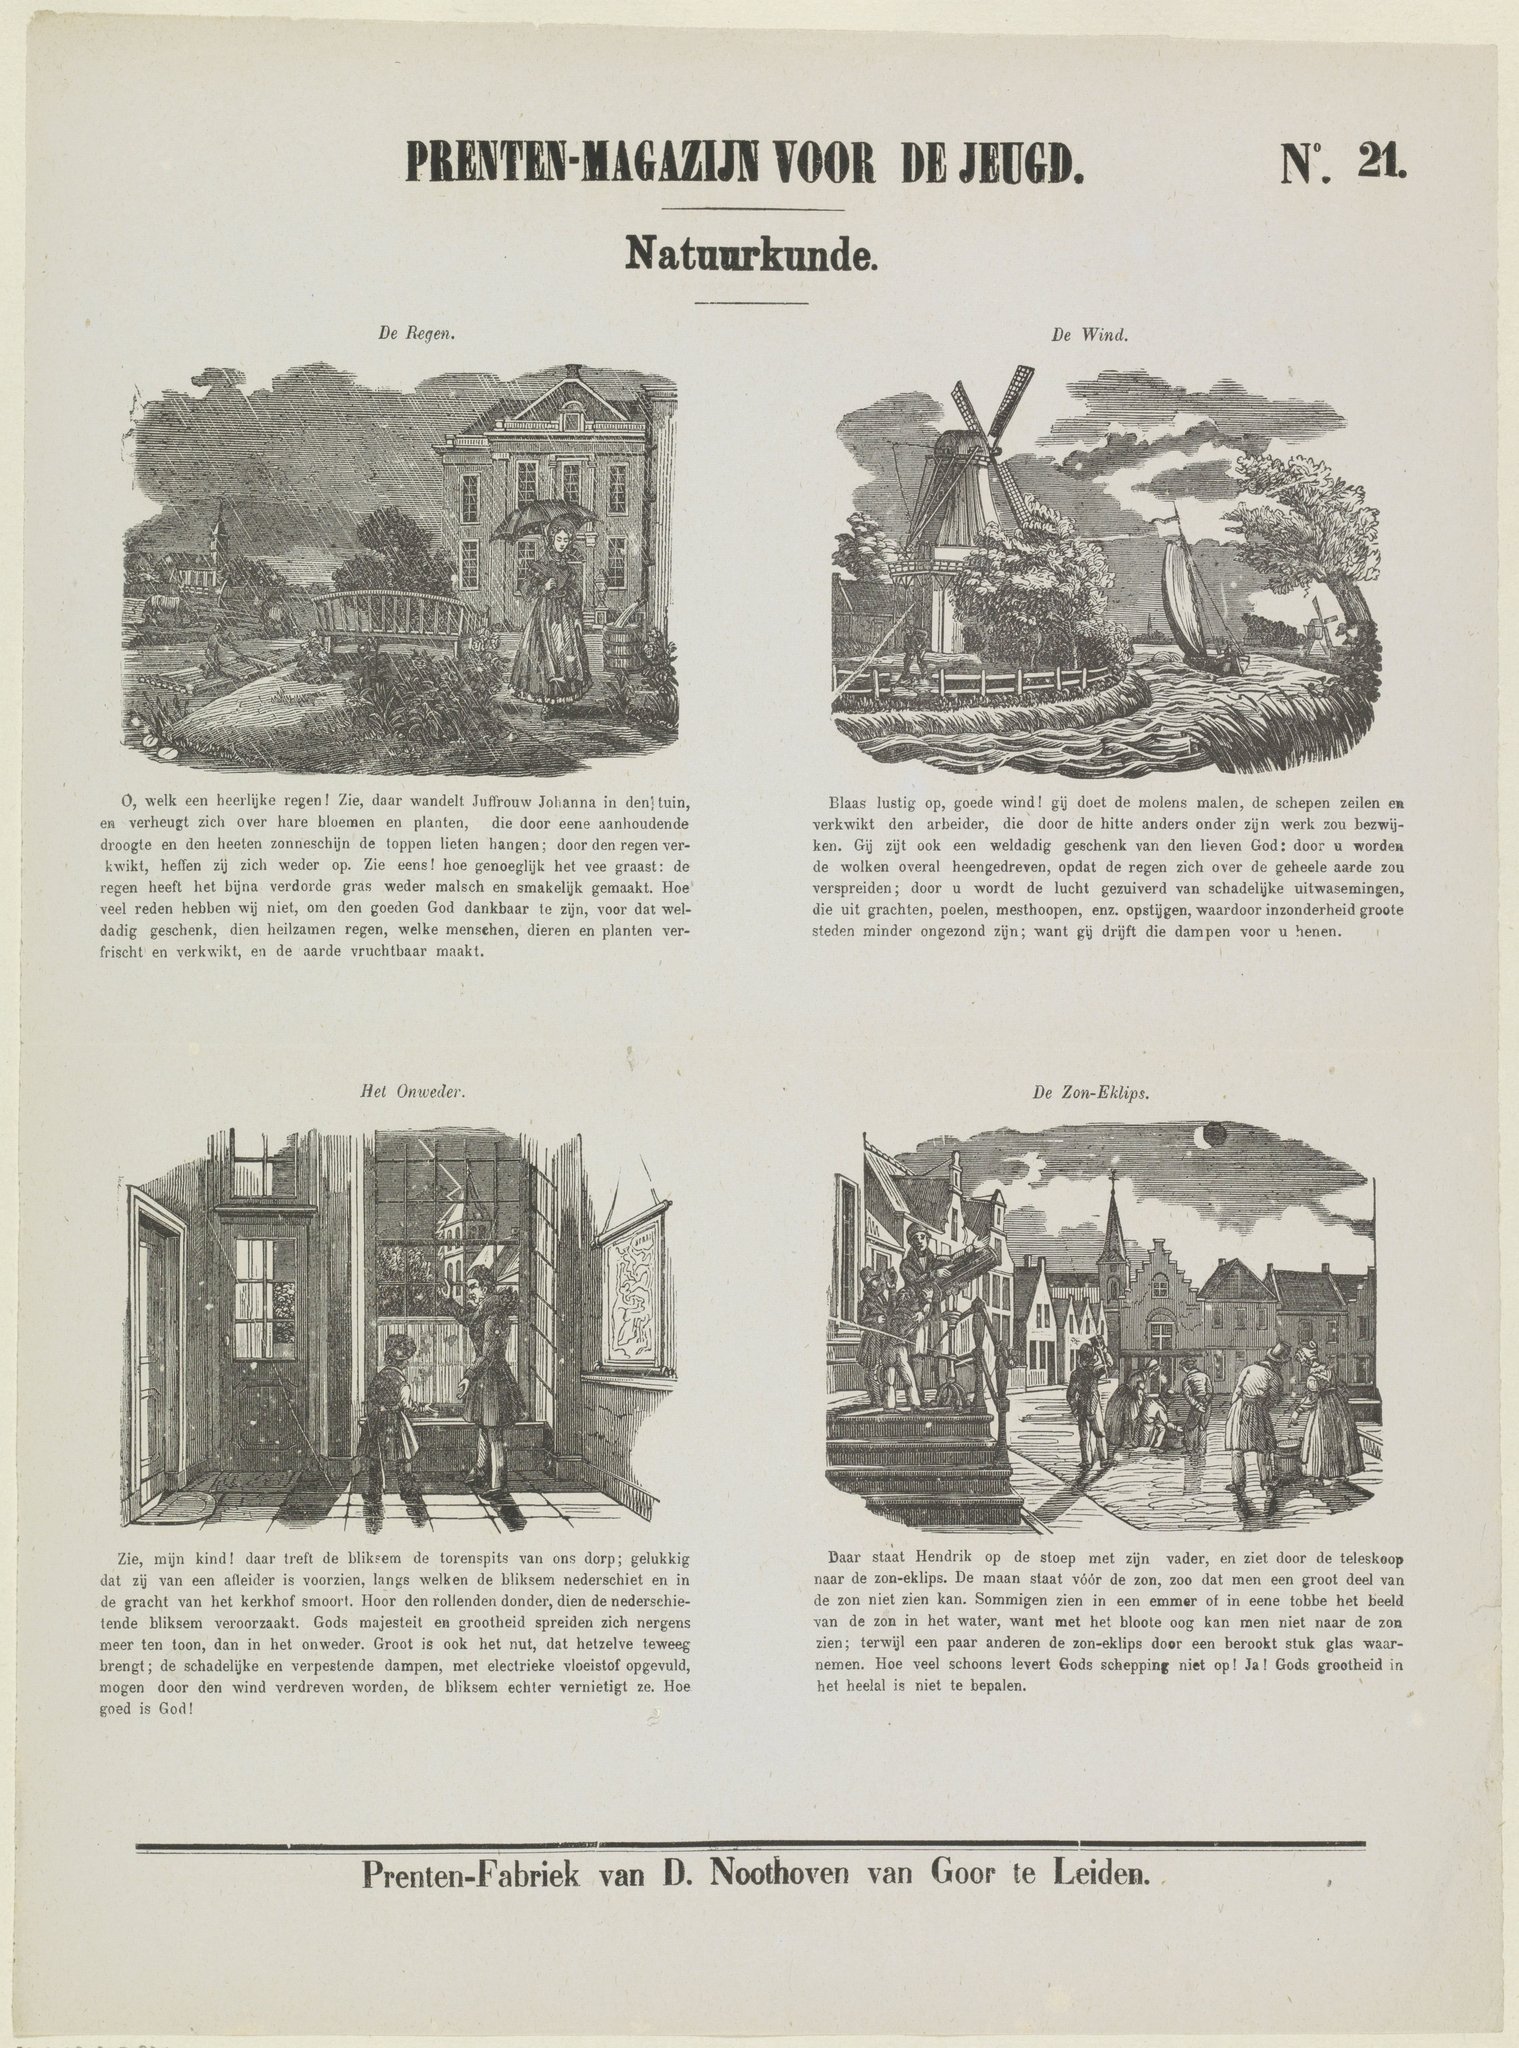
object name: print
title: Regen, wind, onweer en een zonsverduistering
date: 1850-1881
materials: paper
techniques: letterpress printing, engraving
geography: leiden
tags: meteorological phenomena, winds, thunderstorm, rain, solar eclipse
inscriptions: collector's mark: Lugt 2760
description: Blad met 4 voorstellingen van weersverschijnselen: regen, wind, onweer en een zonsverduistering. Boven elke voorstelling een titel en onder elke voorstelling zeven tot negen regels tekst. Genummerd rechtsboven: No. 21.